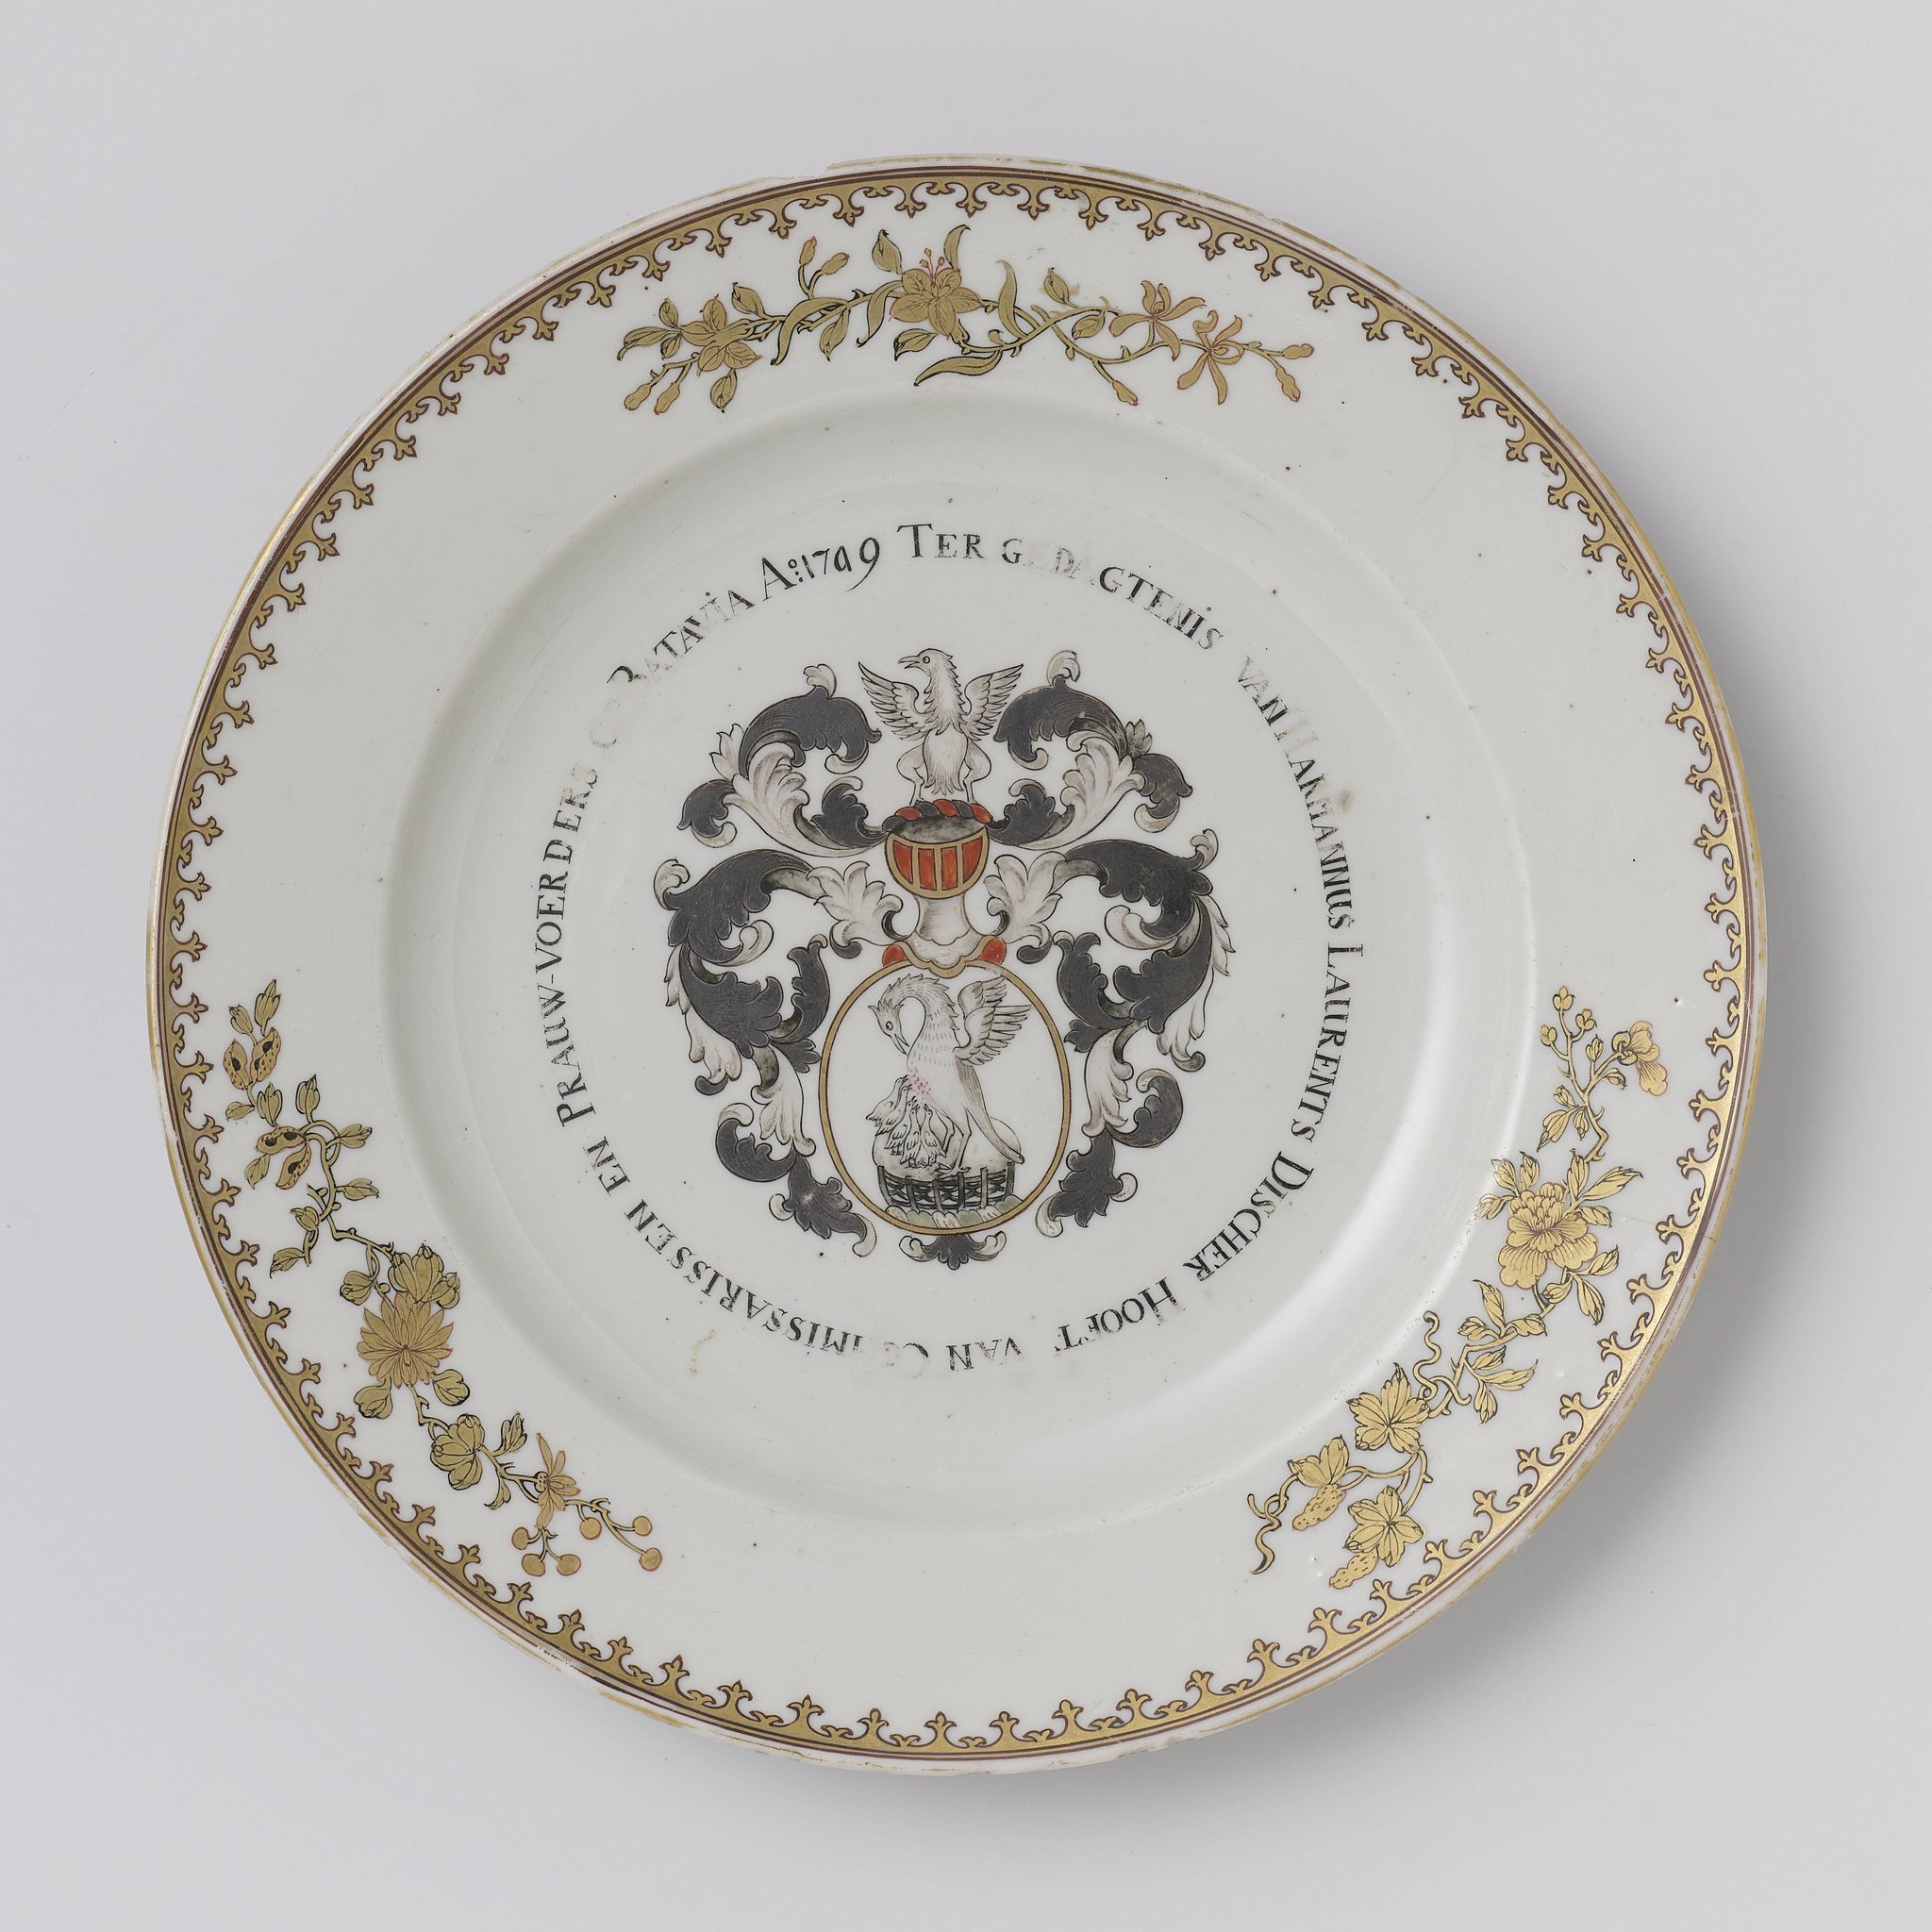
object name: plate dish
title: Memorial plate of Hermannus Laurents Discher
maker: Anonymous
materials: glaze, gold, paint, porcelain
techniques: firing, gilding, turning, vitrification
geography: china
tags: java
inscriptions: inscription: ‘TER GEDACHTENIS VAN HERMANNUS LAURENTS DISCHER HOOFT VAN COMMISSARISSEN EN PRAUW-VOERDERS OP BATAVIA Ao. 1749’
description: Bord van porselein, beschilderd op het glazuur in rood, zwart en goud. Op het plat een wapen met de pelikaan die haar jongen voedt uit haar borst. Het helmteken is een vogel. Het wapen is omgeven door acanthusbladeren. Om het wapen het opschrift: 'TER GEDACHTENIS VAN HERMANNUS LAURENTS DISCHER HOOFT VAN COMMISSARISSEN EN PRAUW-VOERDERS OP BATAVIA Ao. 1749'. Op de rand vier bloemtakken (pioen, chrysant, iris) en een spearhead-border. Een chip en een barst in de rand. Wapenporselein met emailkleuren.